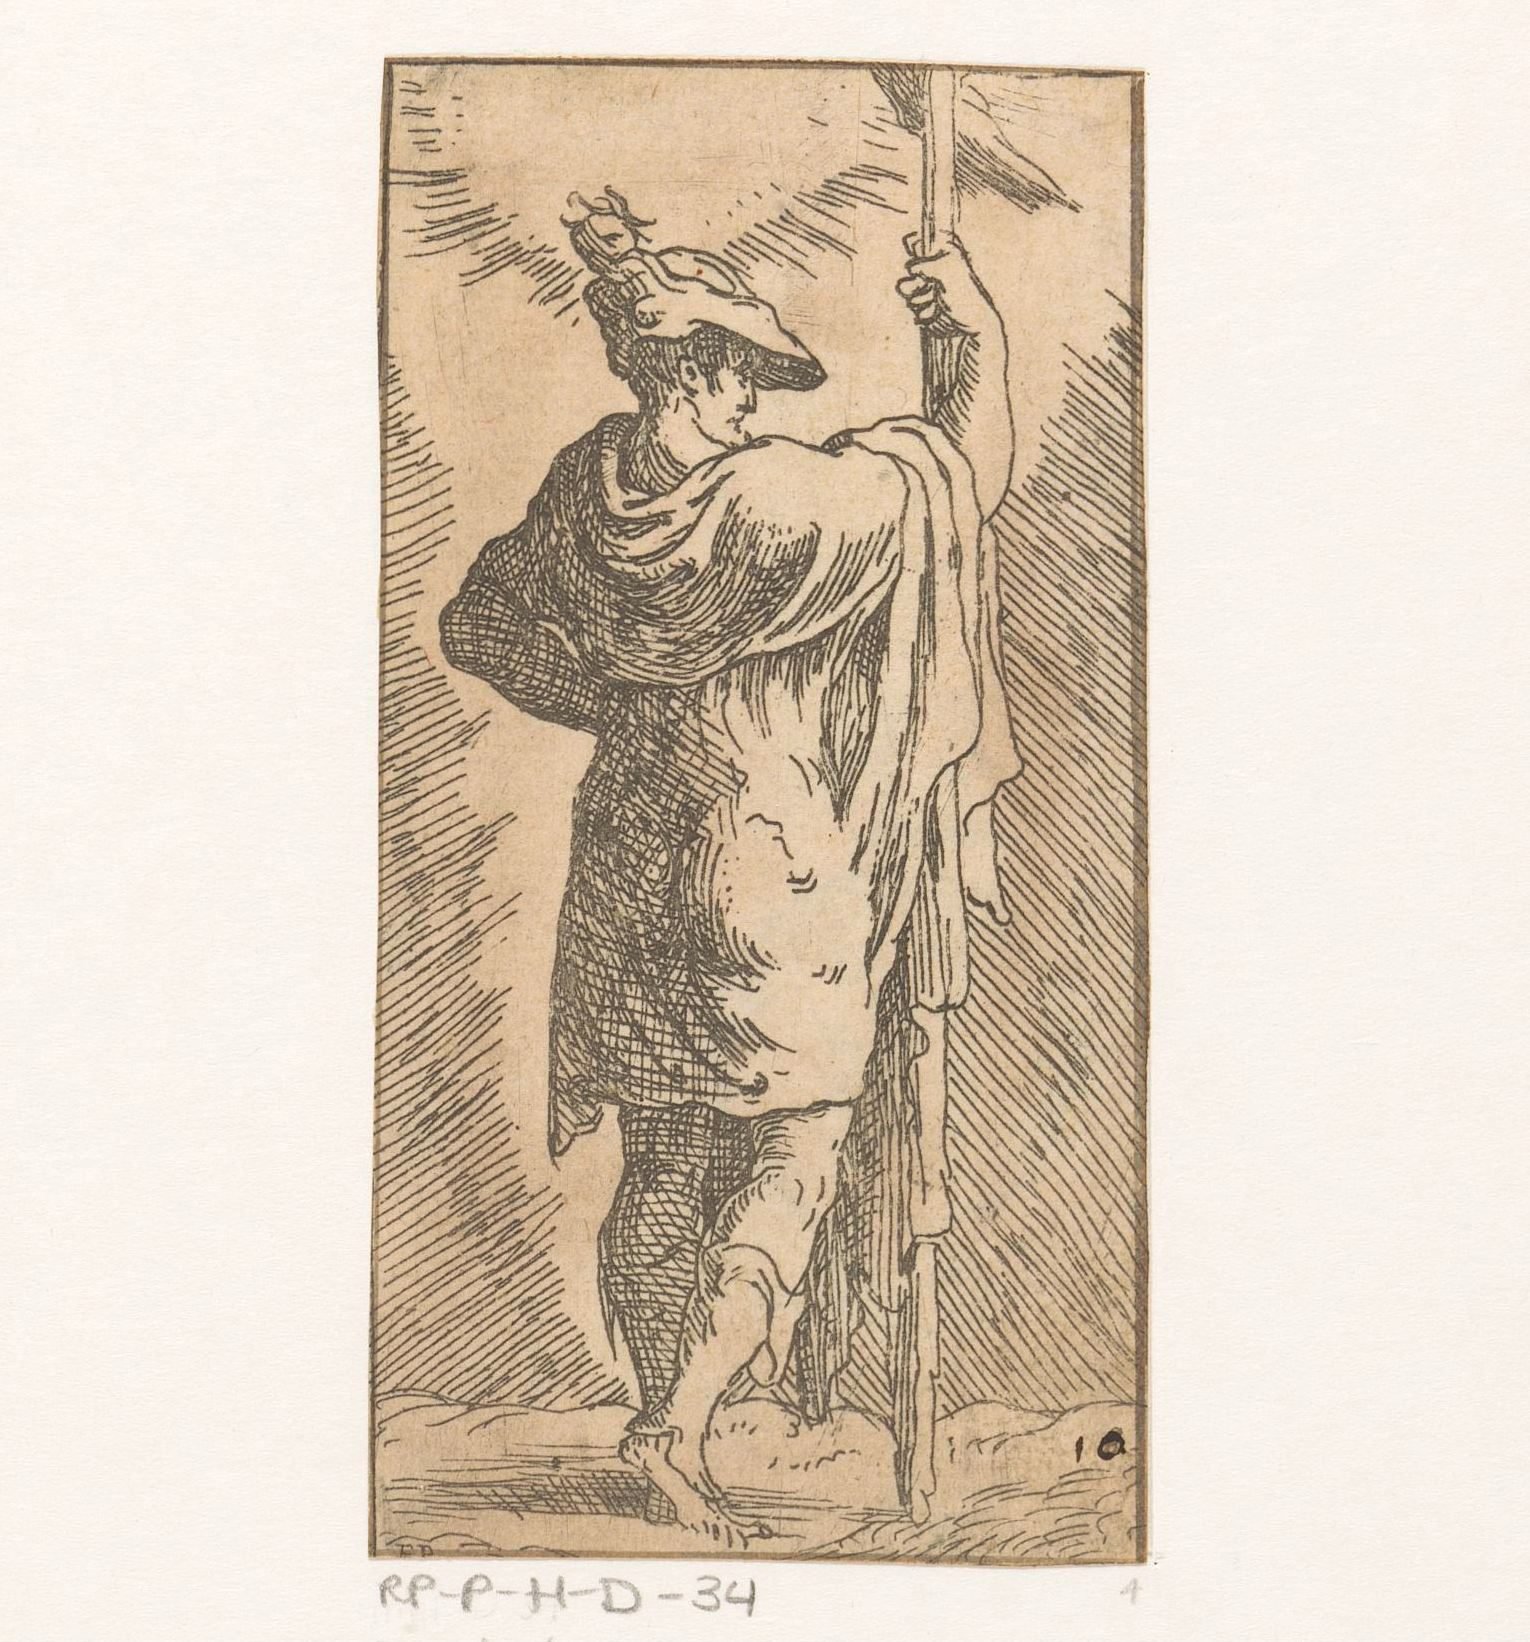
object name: print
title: Heilige Jakobus de Meerdere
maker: monogrammist fp (italië; 16e eeuw)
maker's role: print maker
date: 1500-1599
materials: paper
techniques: etching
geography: italy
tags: the apostle james the great; possible attributes: book, pilgrim's cloak, hat, shell, staff, and wallet, scroll, sword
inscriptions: collector's mark: ‘Hinloopen’, number: ‘10’, collector's mark: Lugt 10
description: Deze prent maakt deel uit van een reeks van dertien prenten van Christus en de twaalf apostelen.